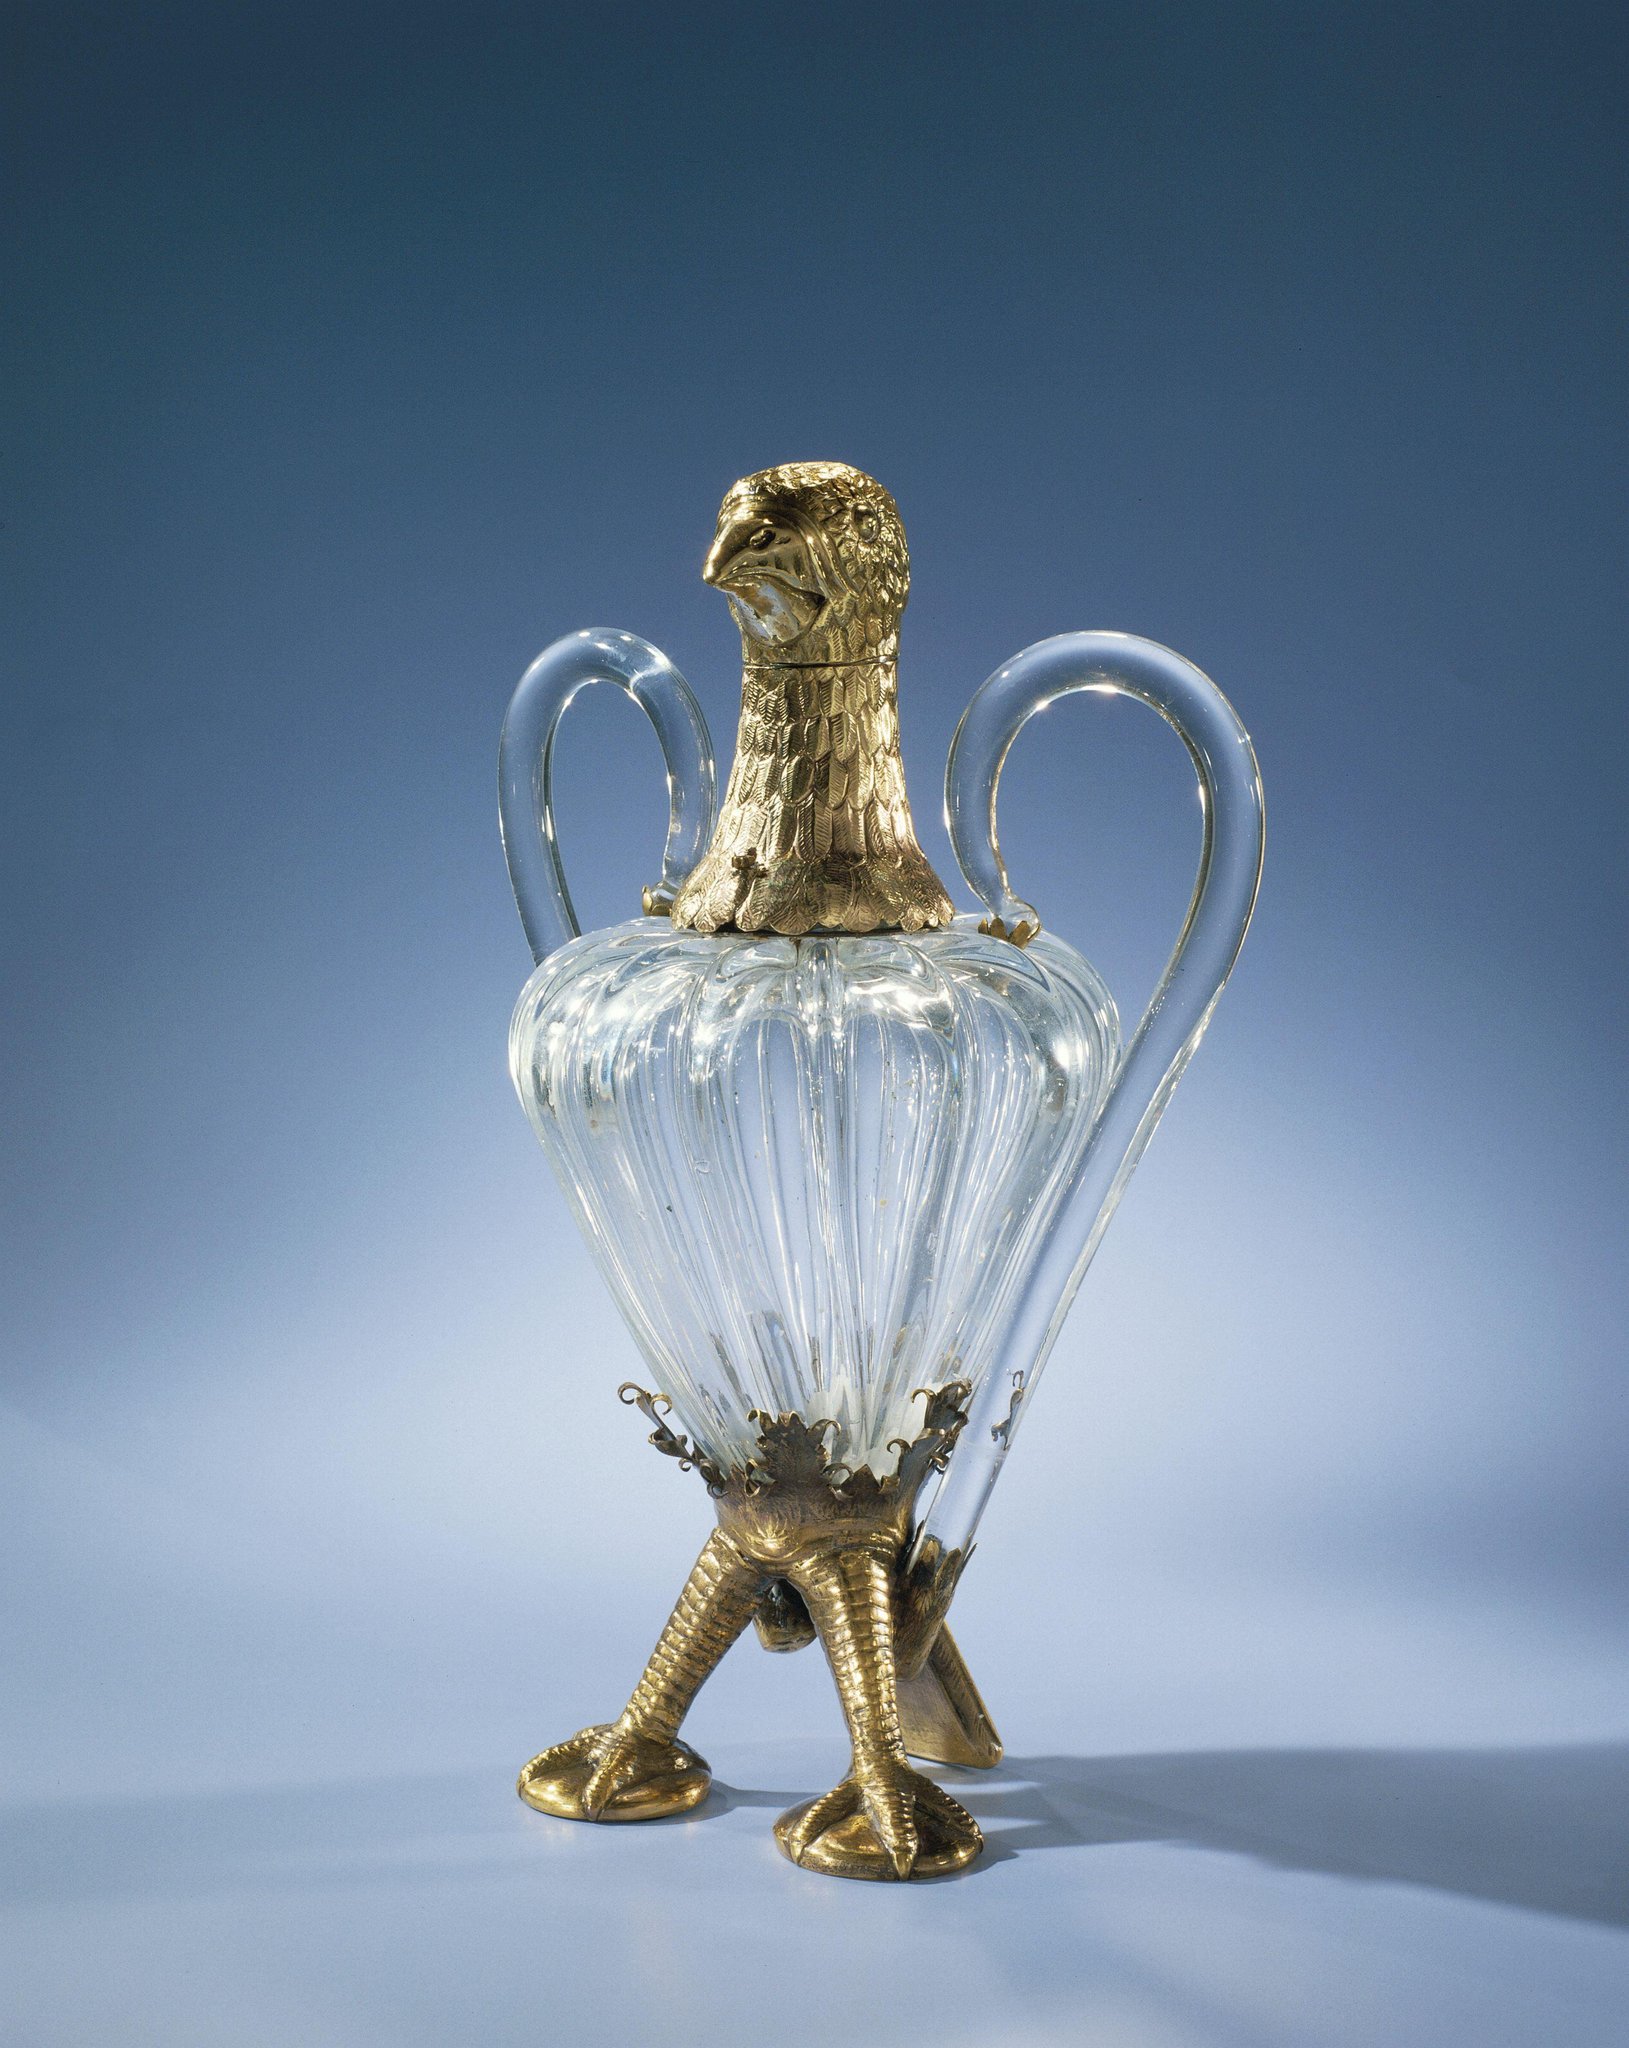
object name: bung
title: Stop van karaf in de vorm van een adelaarskop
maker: Anonymous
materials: glass, silver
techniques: engraving, gilding, glassblowing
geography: germany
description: De afneembare kop fungeert als stop. Kop IS gegraveerd met schubben; de staart, nek en kop met veren.